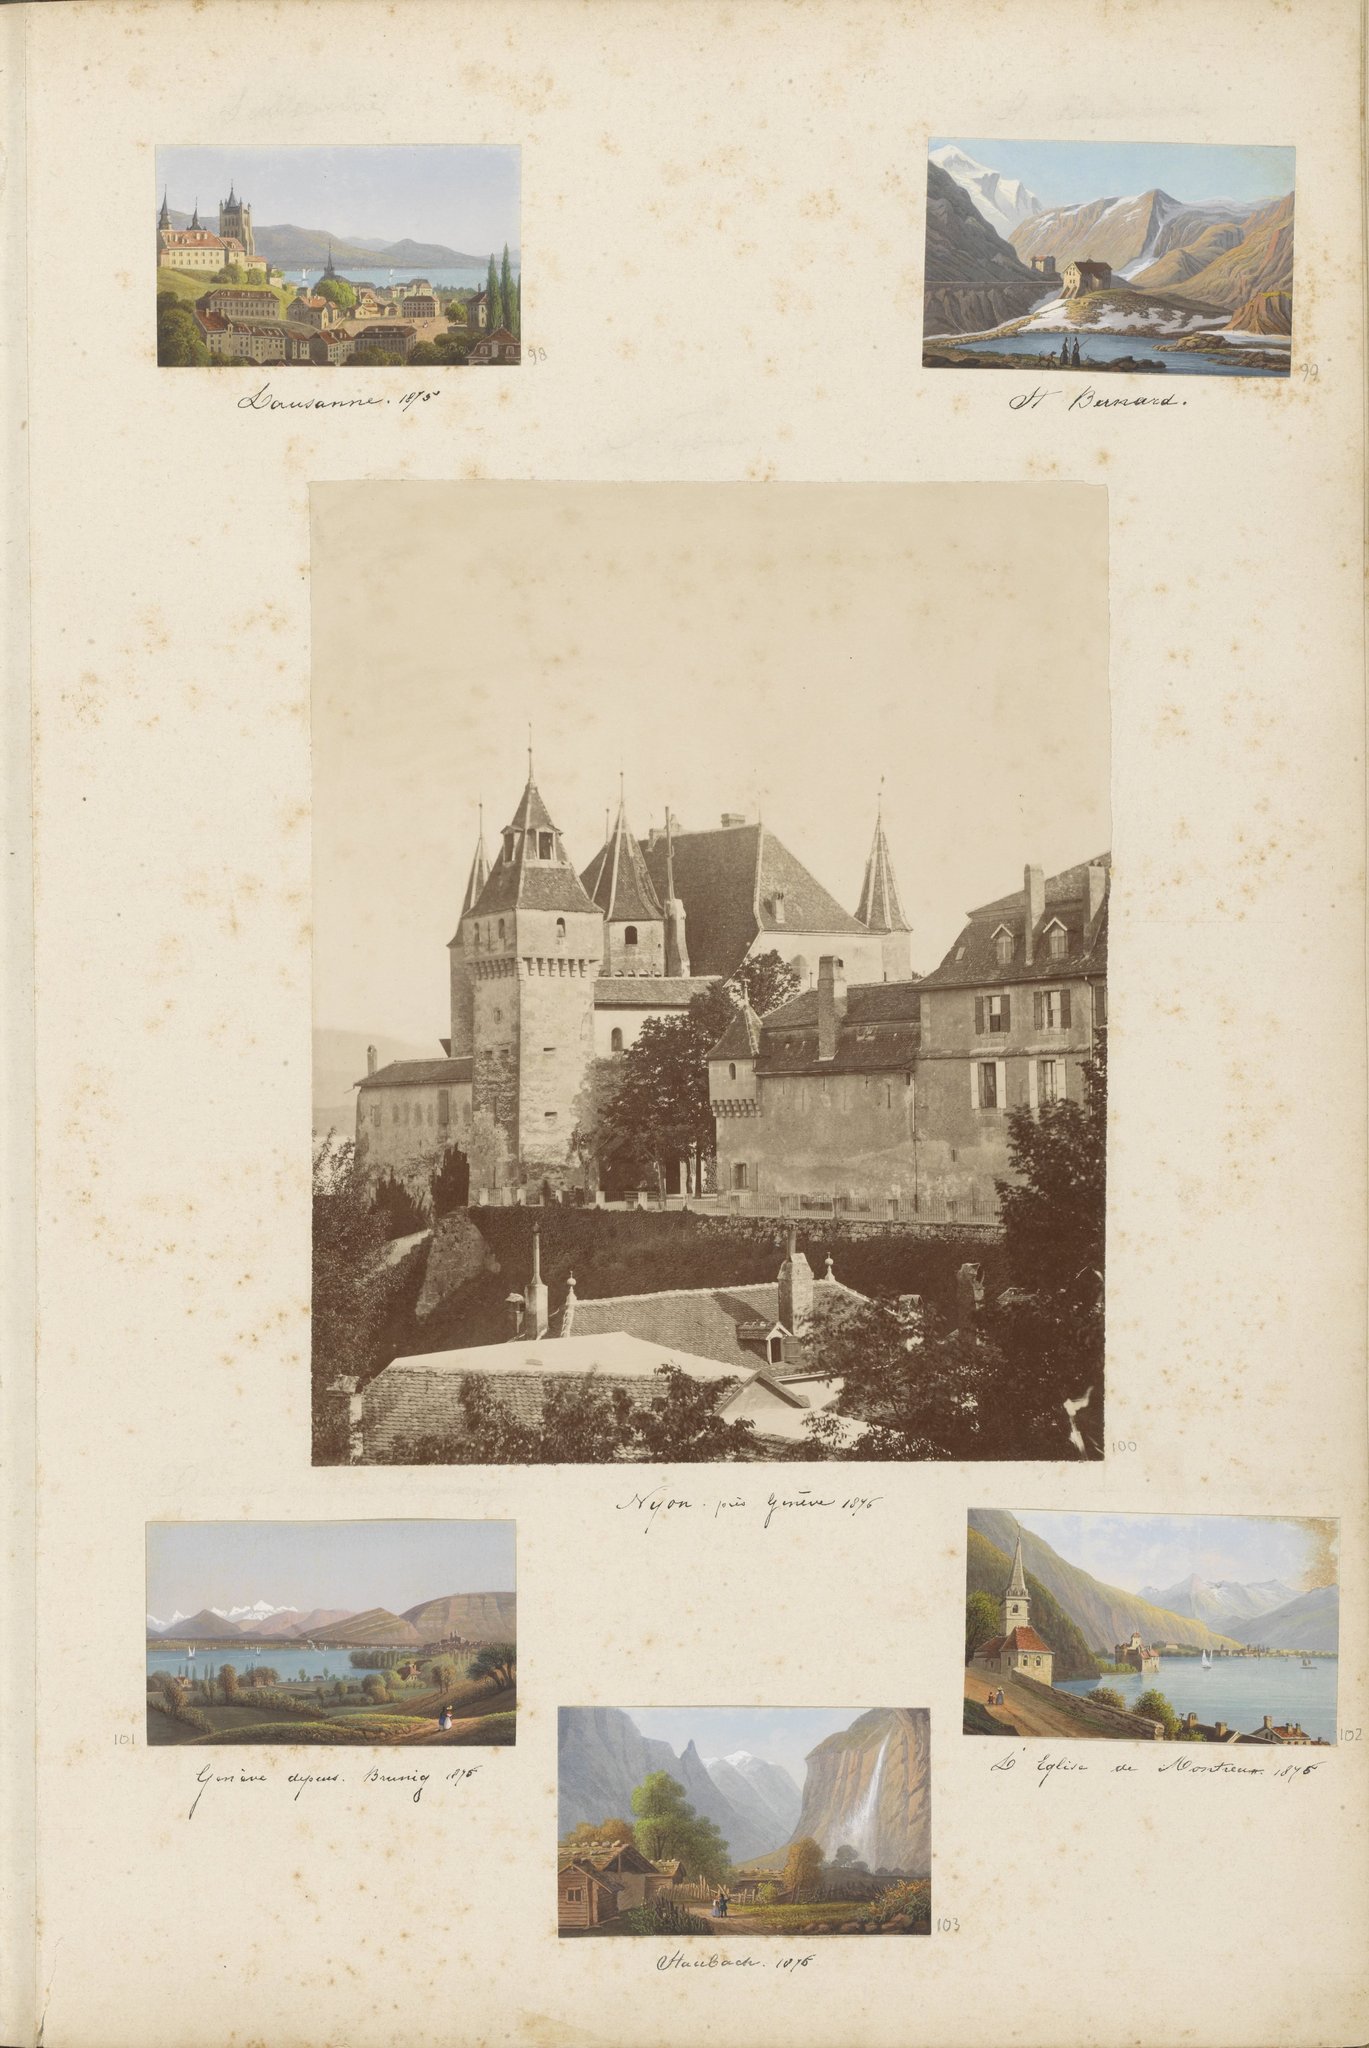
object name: album leaf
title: Gezicht op Lausanne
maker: Anonymous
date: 1876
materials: paper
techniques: lithograph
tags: prospect of city, town panorama, silhouette of city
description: Onderdeel van Fotoalbum van Robert Daniel Crommelin (1841-1907).